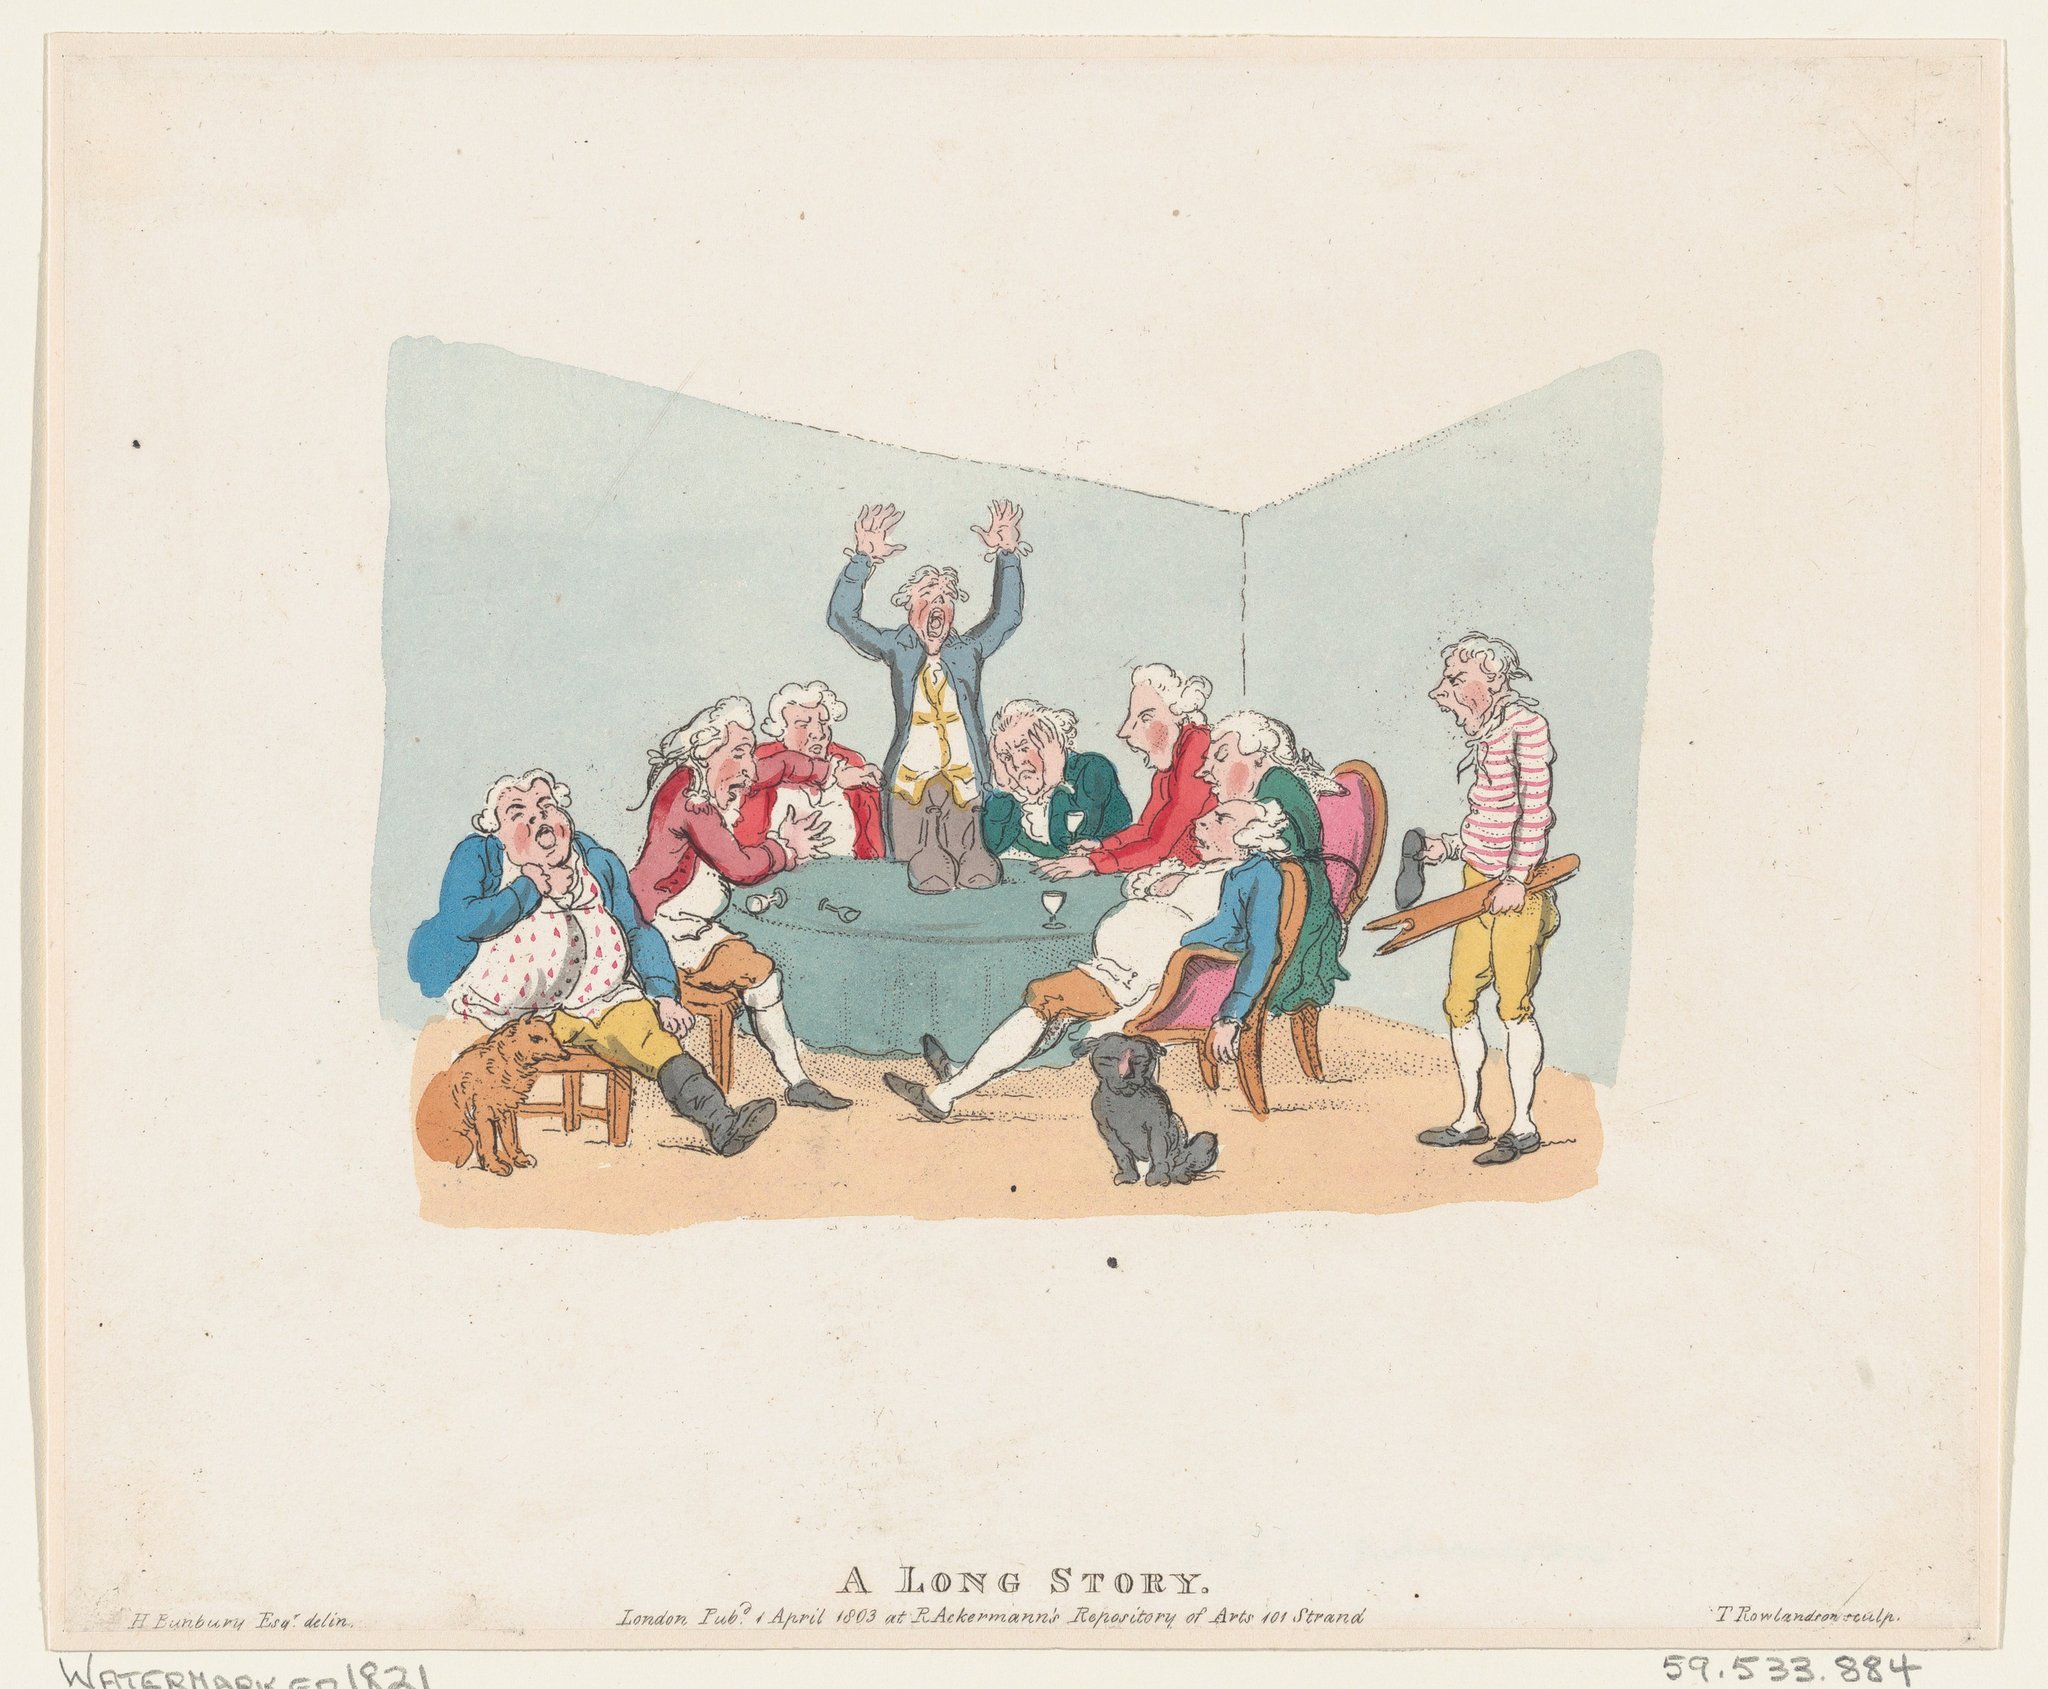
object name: print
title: A Long Story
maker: thomas rowlandson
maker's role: artist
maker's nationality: british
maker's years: 1757-1827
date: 1803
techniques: etching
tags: satire,men,dogs,servants